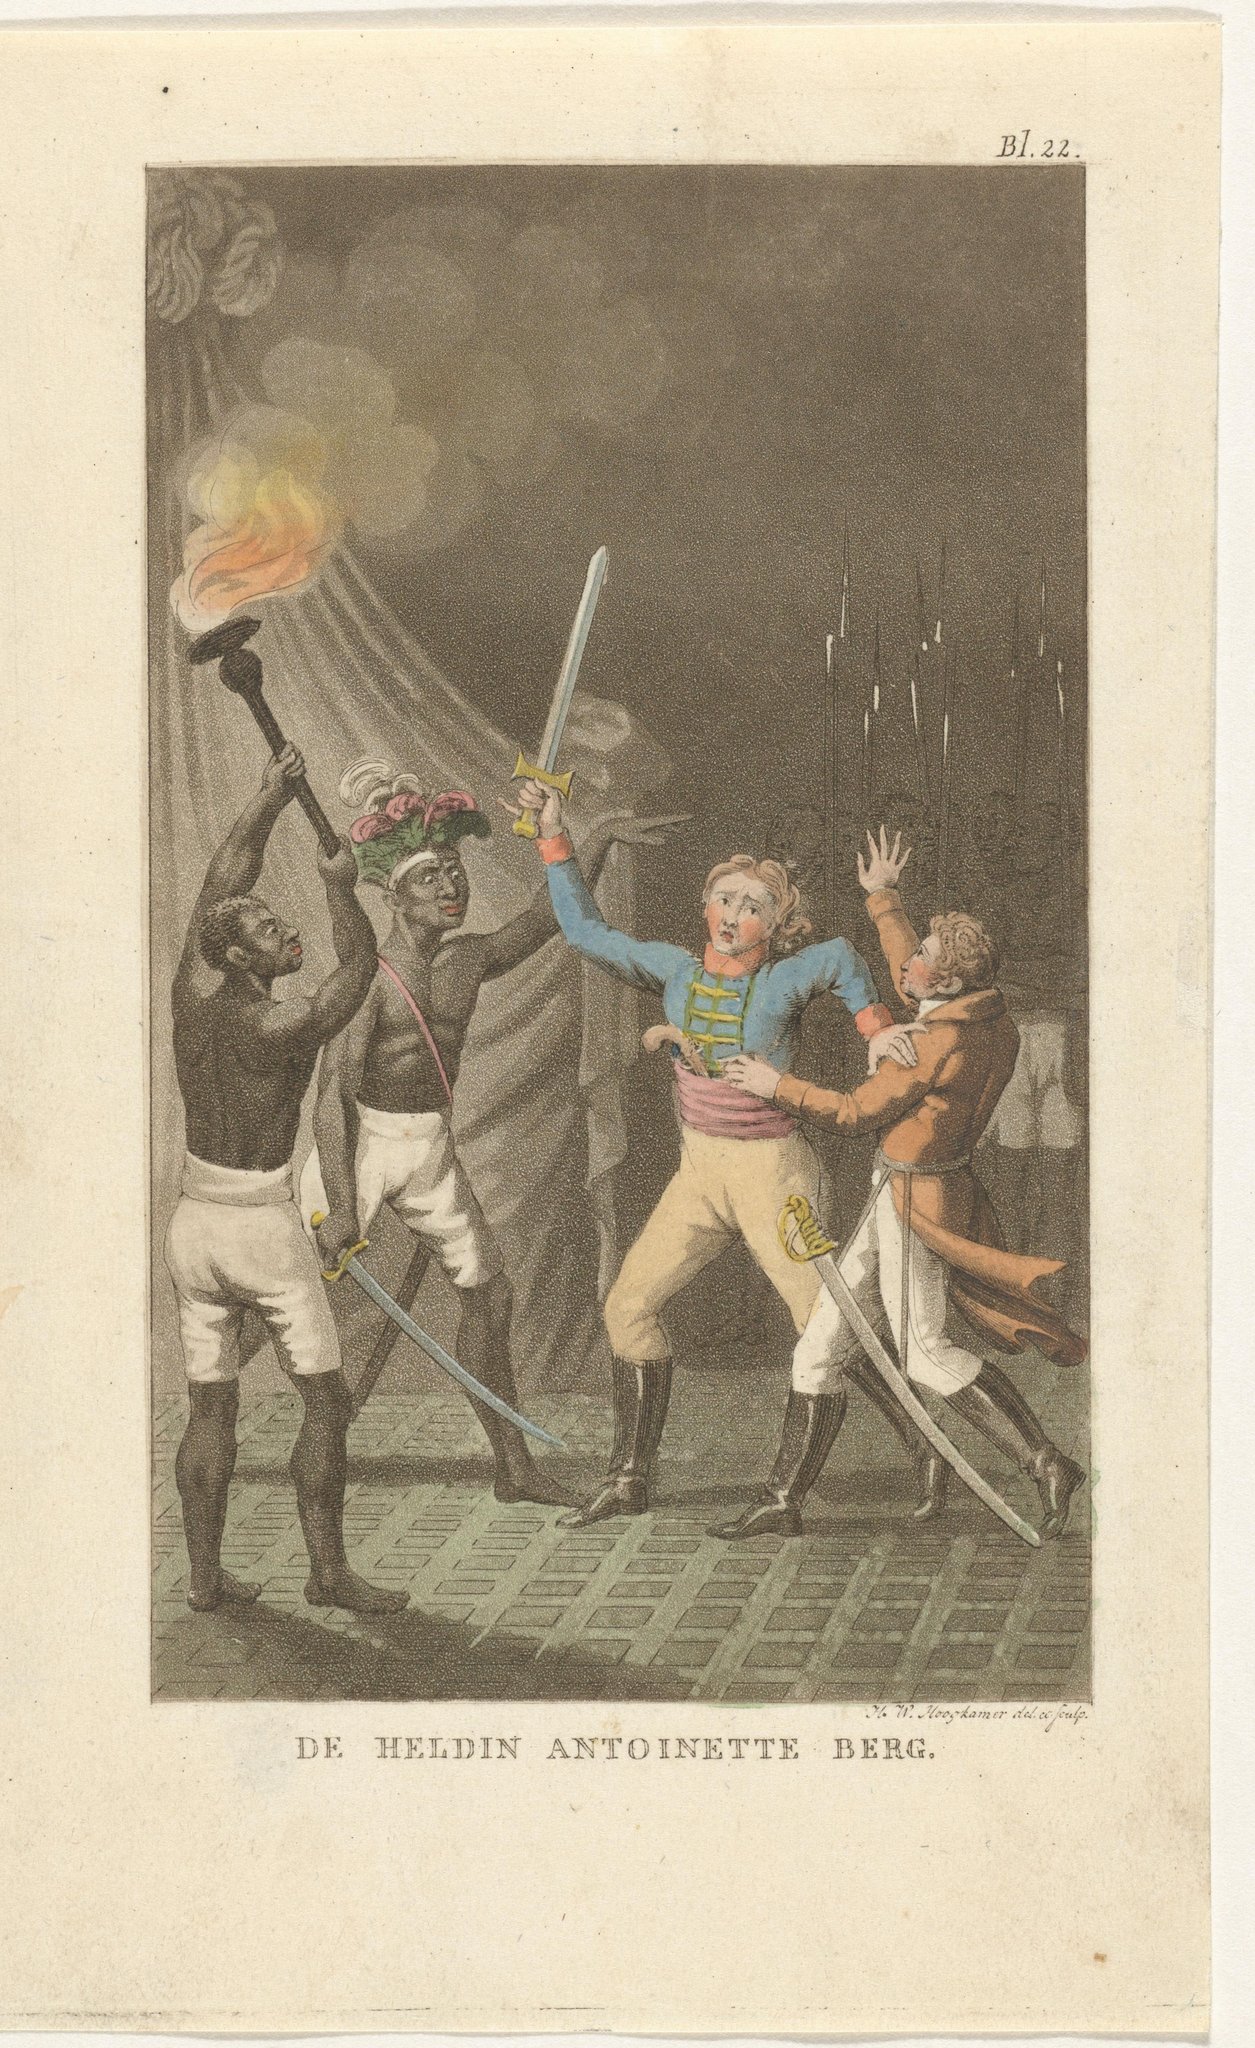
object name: book illustration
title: Twee figuren met zwaarden bij twee zwarte mannen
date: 1820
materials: paper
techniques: aquatint, etching, hand coloring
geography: amsterdam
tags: torch, africans, hacking and thrusting weapons: sword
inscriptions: collector's mark: Lugt 2760, collector's mark: Lugt 2228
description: Boekillustratie voor: De heldin Antoinette Berg, in: Museum Des Buitengewonen En Wondervollen,: behelzende Ware Gebeurtenissen Uit Onzen Leeftijd. Amsterdam: C.L. Schleijer, 1820.